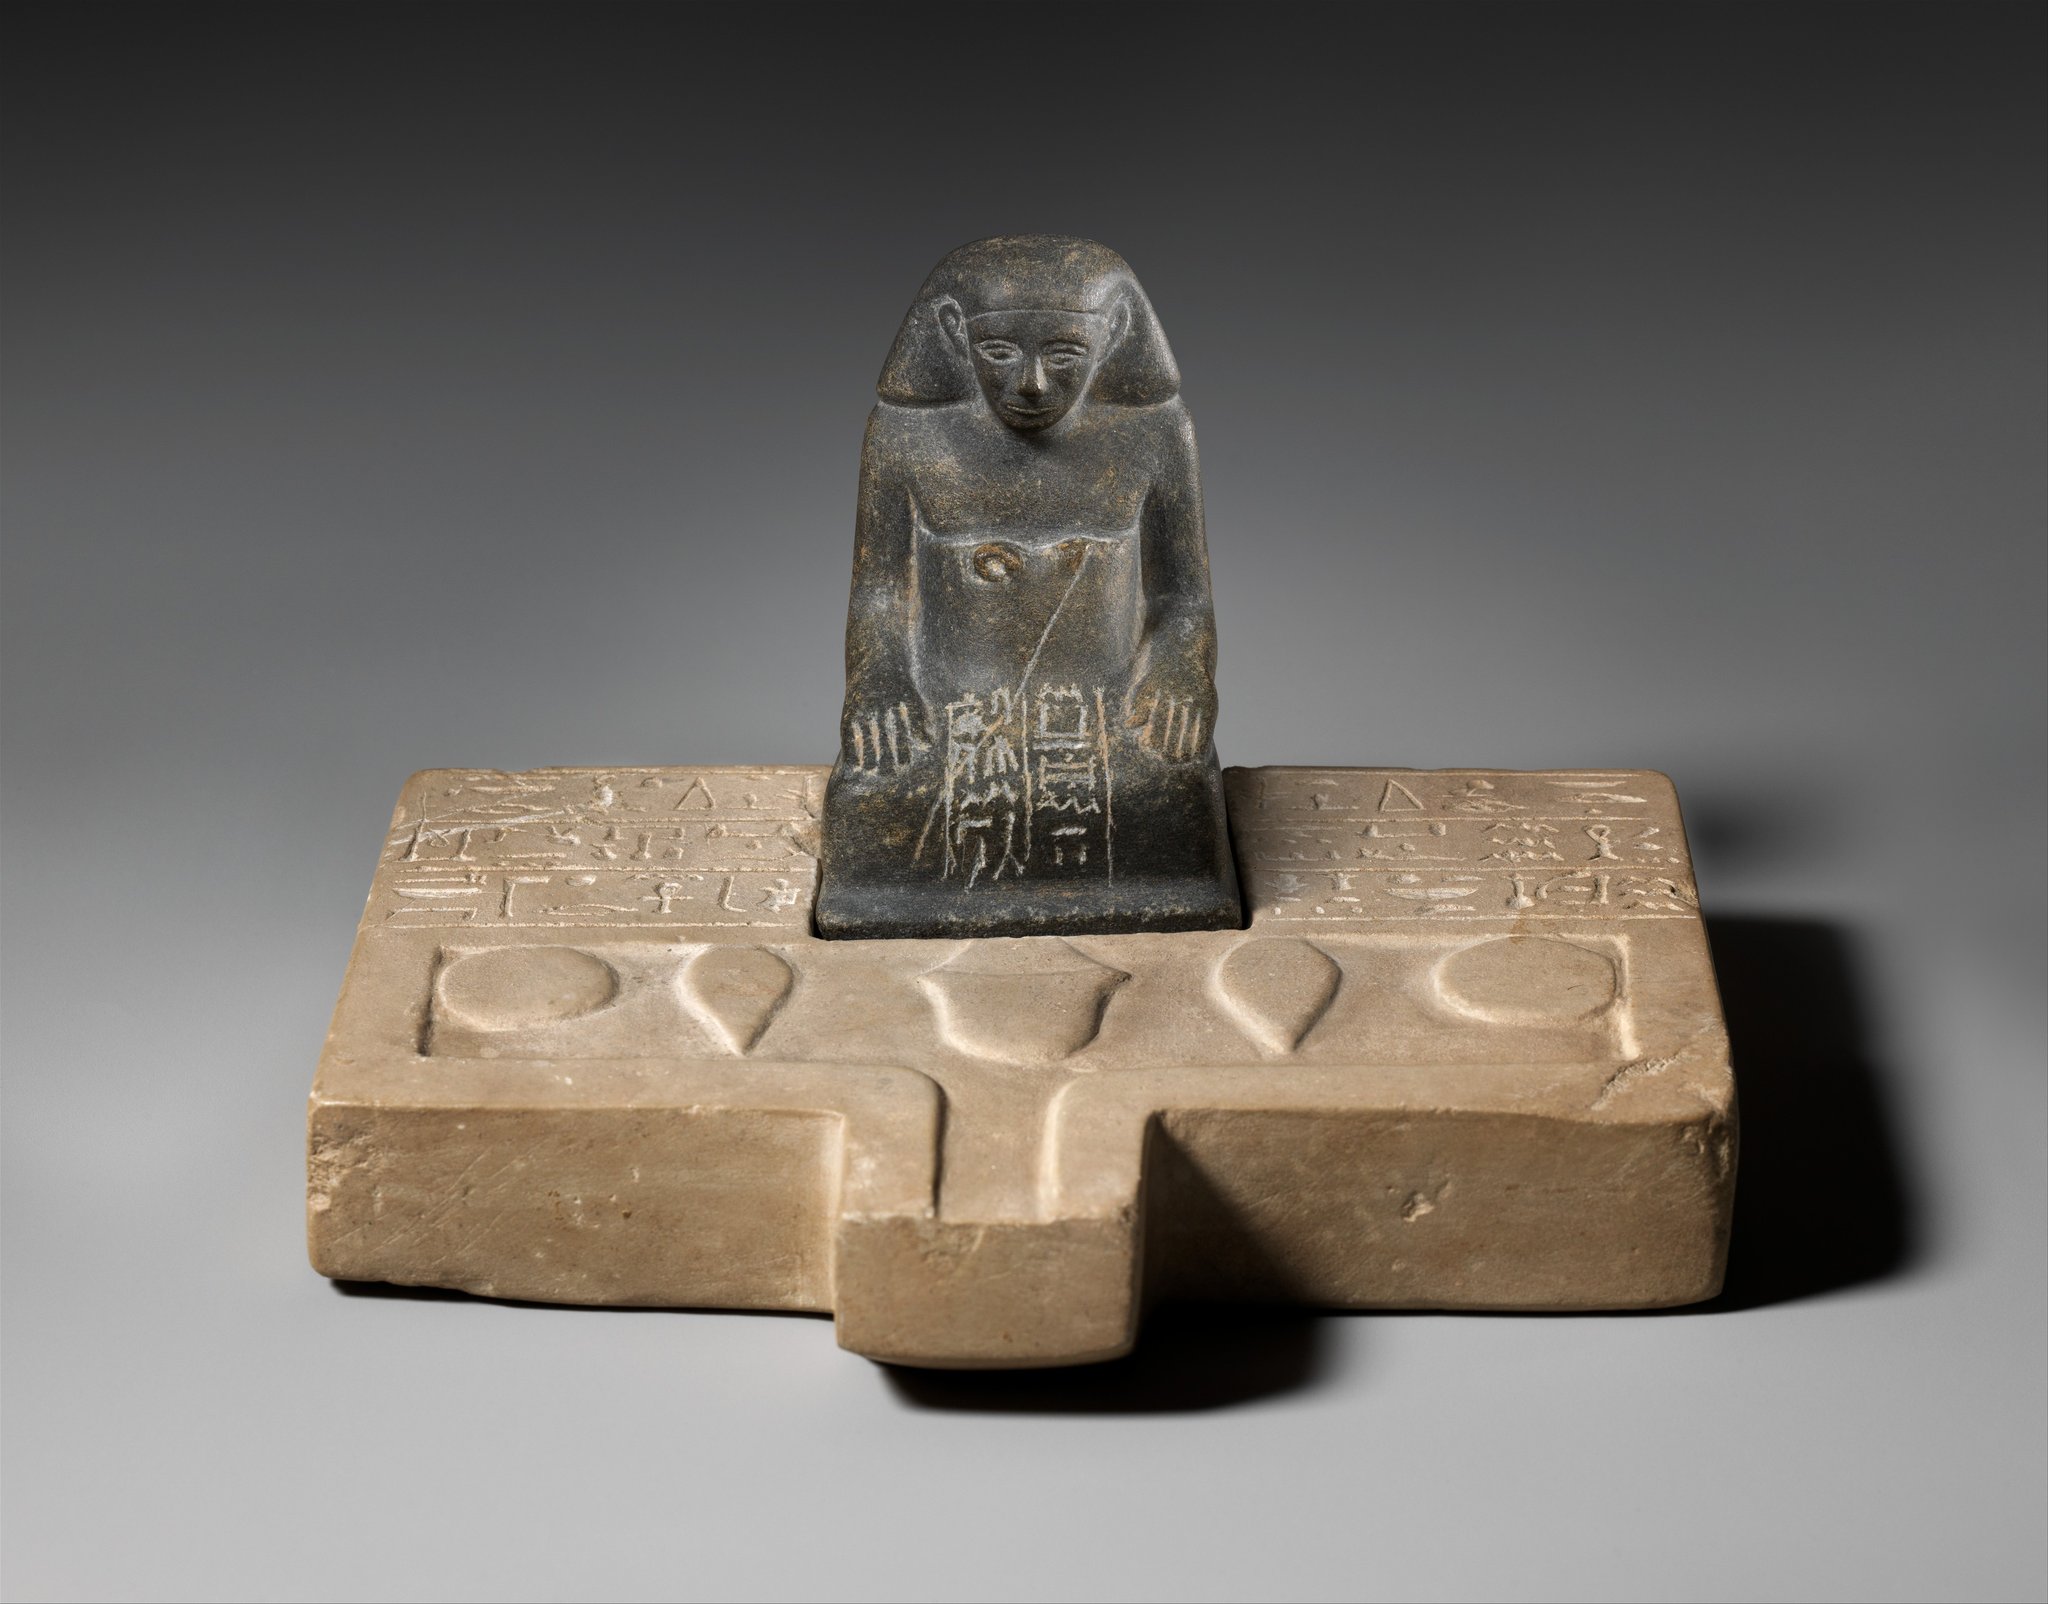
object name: offering table, with statuette of sehetepib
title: Offering table with statuette of Sehetepib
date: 1850-1775 BCE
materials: limestone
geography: egypt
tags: human figures